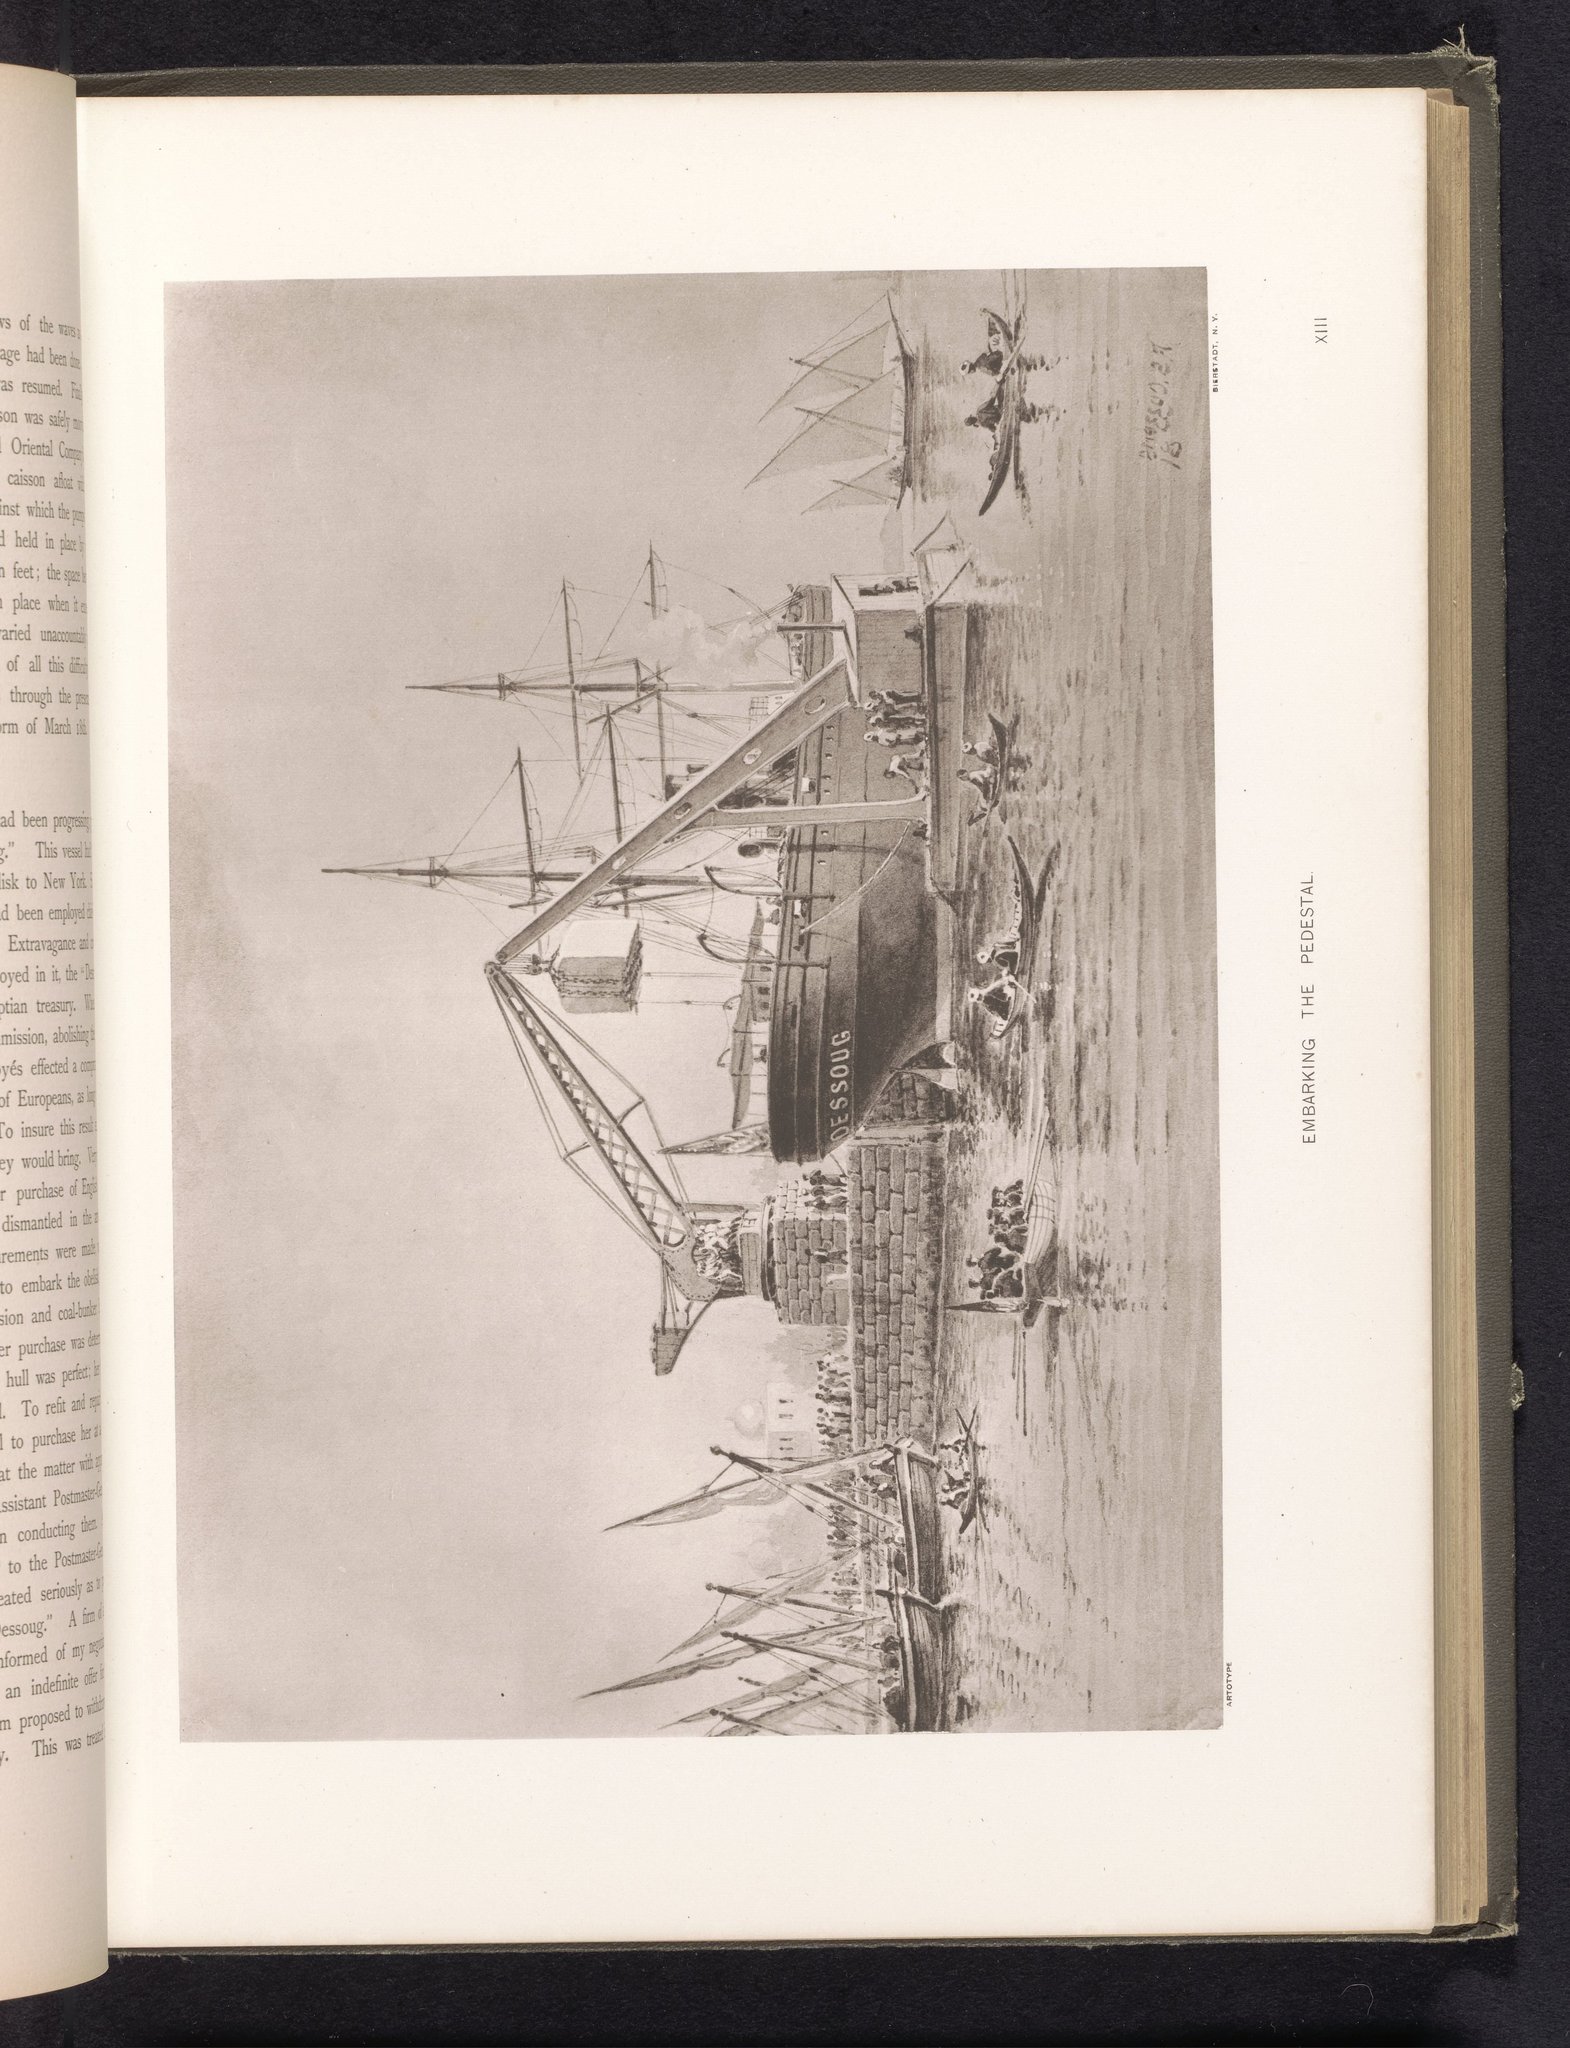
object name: reproduction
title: Embarking the pedestal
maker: Anonymous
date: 1879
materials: paper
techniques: photograph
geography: new york city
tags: obelisk, needle, ships (in general), base (~ column, pillar)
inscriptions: number: ‘Plate XIII’